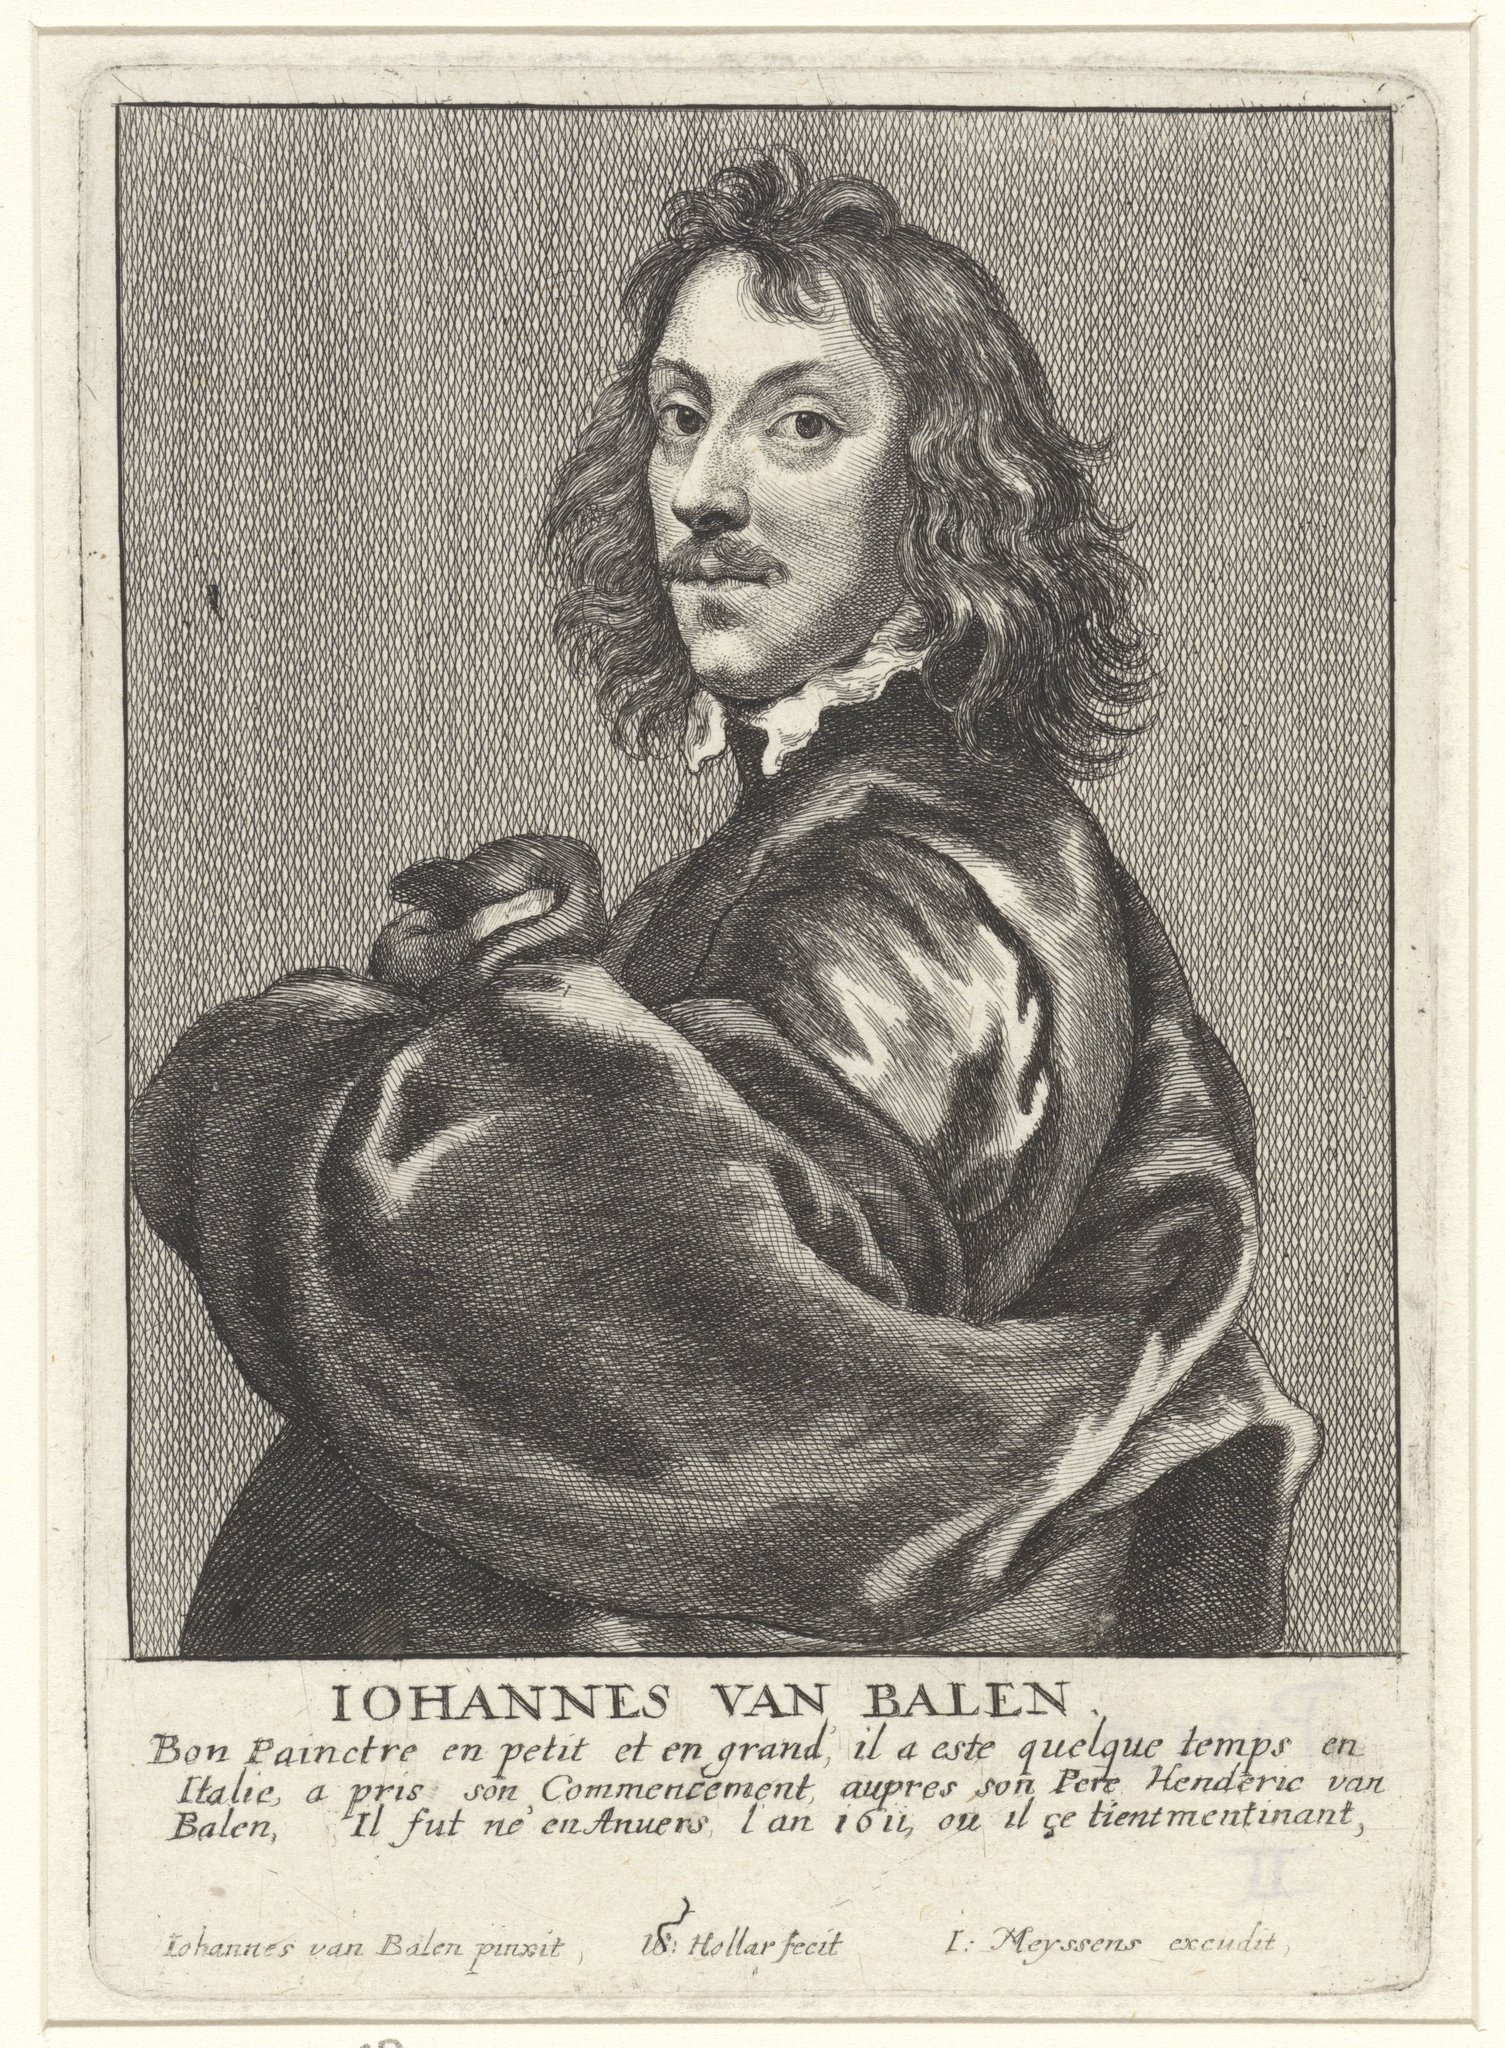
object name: print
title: Portretten van kunstenaars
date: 1649-1670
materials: paper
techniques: etching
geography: antwerp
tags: antwerp, painter, draughtsman, jan van balen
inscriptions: collector's mark: Lugt 240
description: De prent maakt deel uit van de negendelige serie "Image de divers hommes desprit sublime".